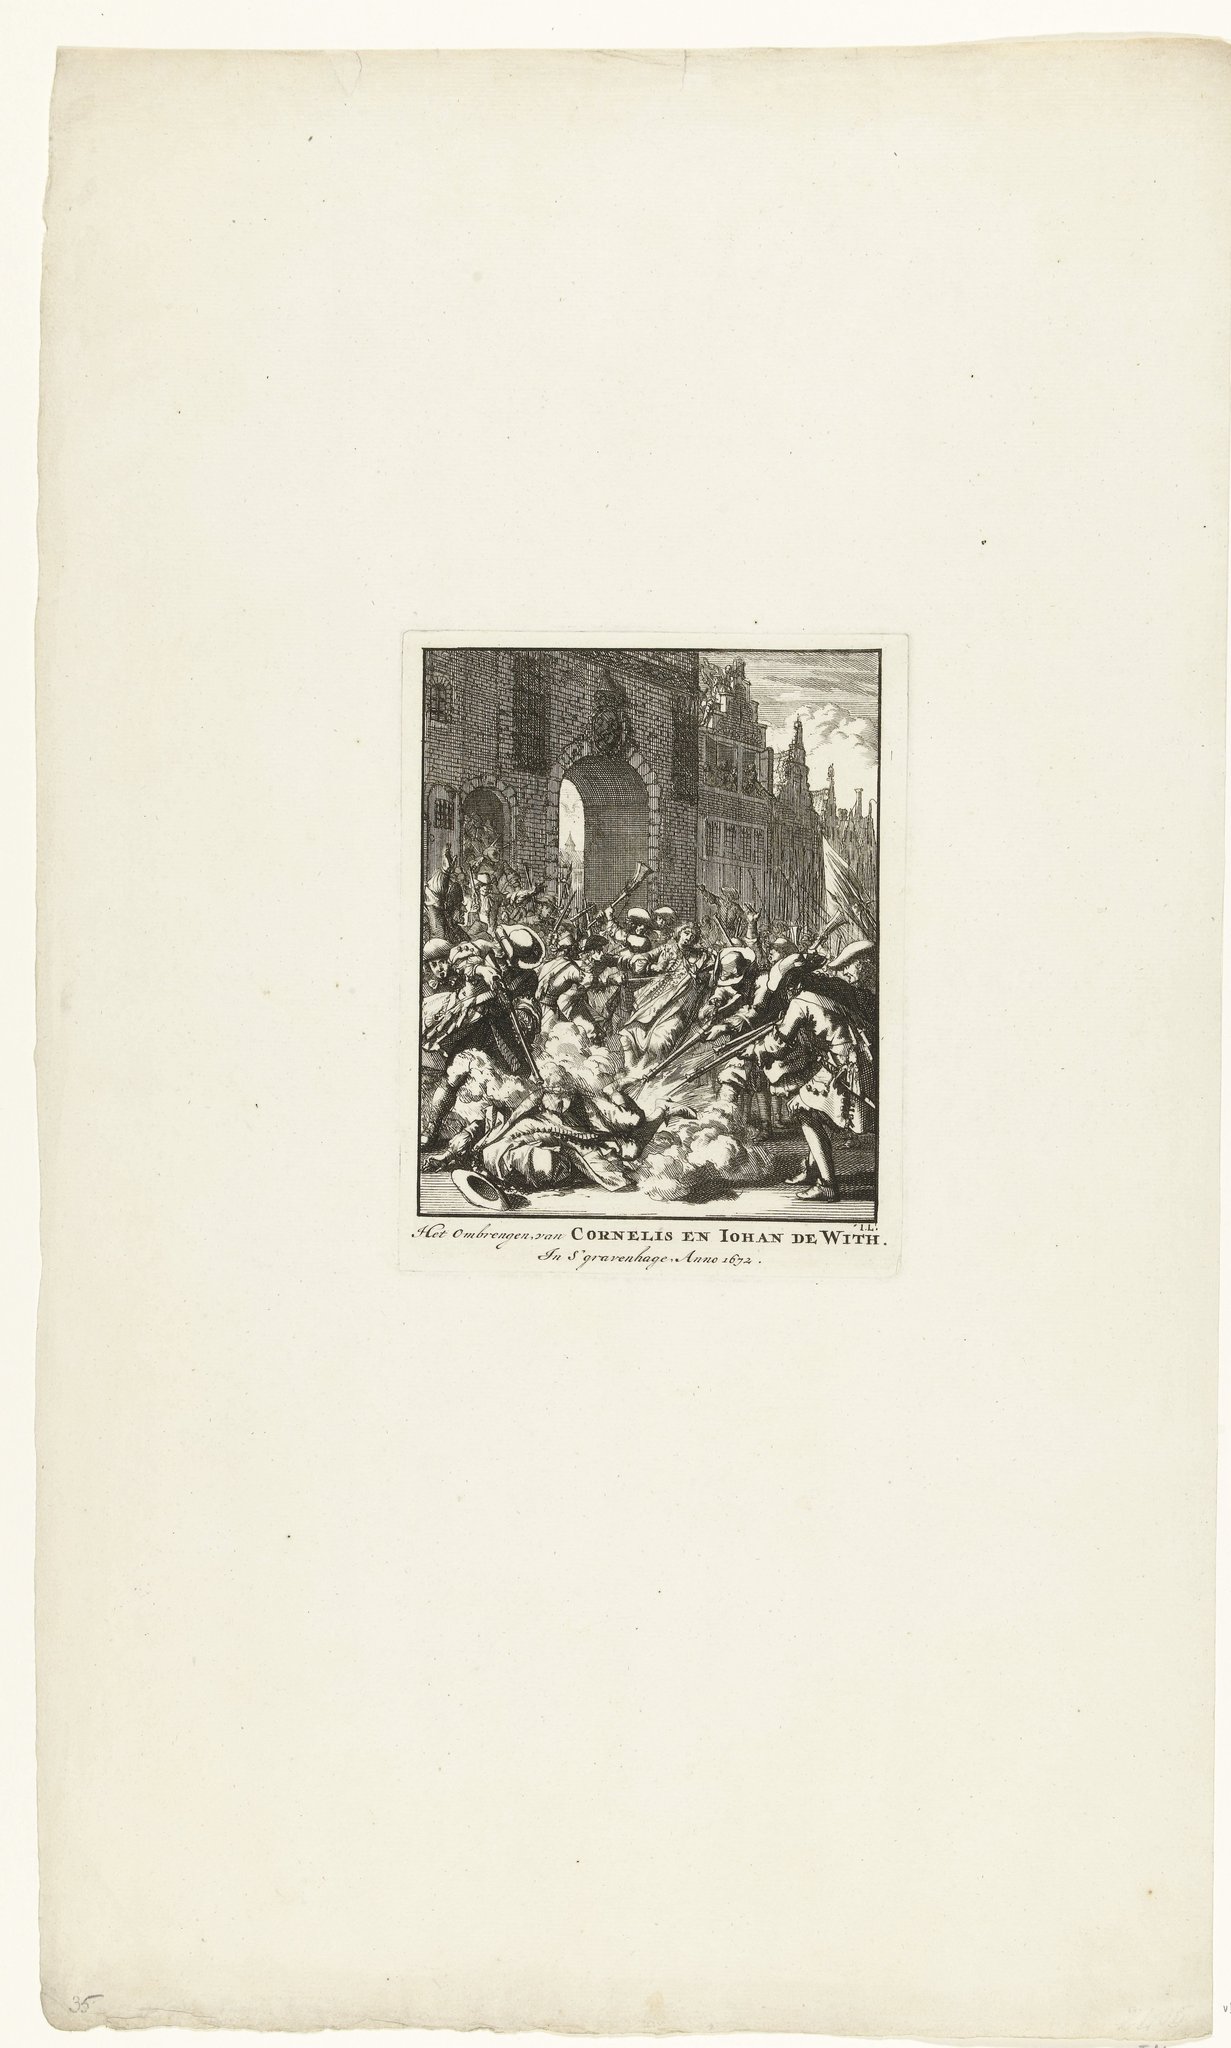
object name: print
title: De moord op de gebroeders De Witt, 1672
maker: jan luyken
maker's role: draughtsman, print maker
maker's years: 1649-1712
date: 1698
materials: paper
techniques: engraving, etching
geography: amsterdam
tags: dordrecht, the hague, cornelis de witt, johan de witt, lynching, attempt, political murder, violent death, being killed; being mishandled and maltreated; seeking death (+ death by lynching)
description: Andere staat van prent ook gebruikt in: Bosch, Lambert van den. Treur-toonneel der doorluchtige mannen, of op- en ondergang der grooten, vertoont in de rampzalige geschiedenissen van […]. 3 delen. Amsterdam: Jan Claesz ten Hoorn, 1698, dl. 3, afd. 6, p. 48.